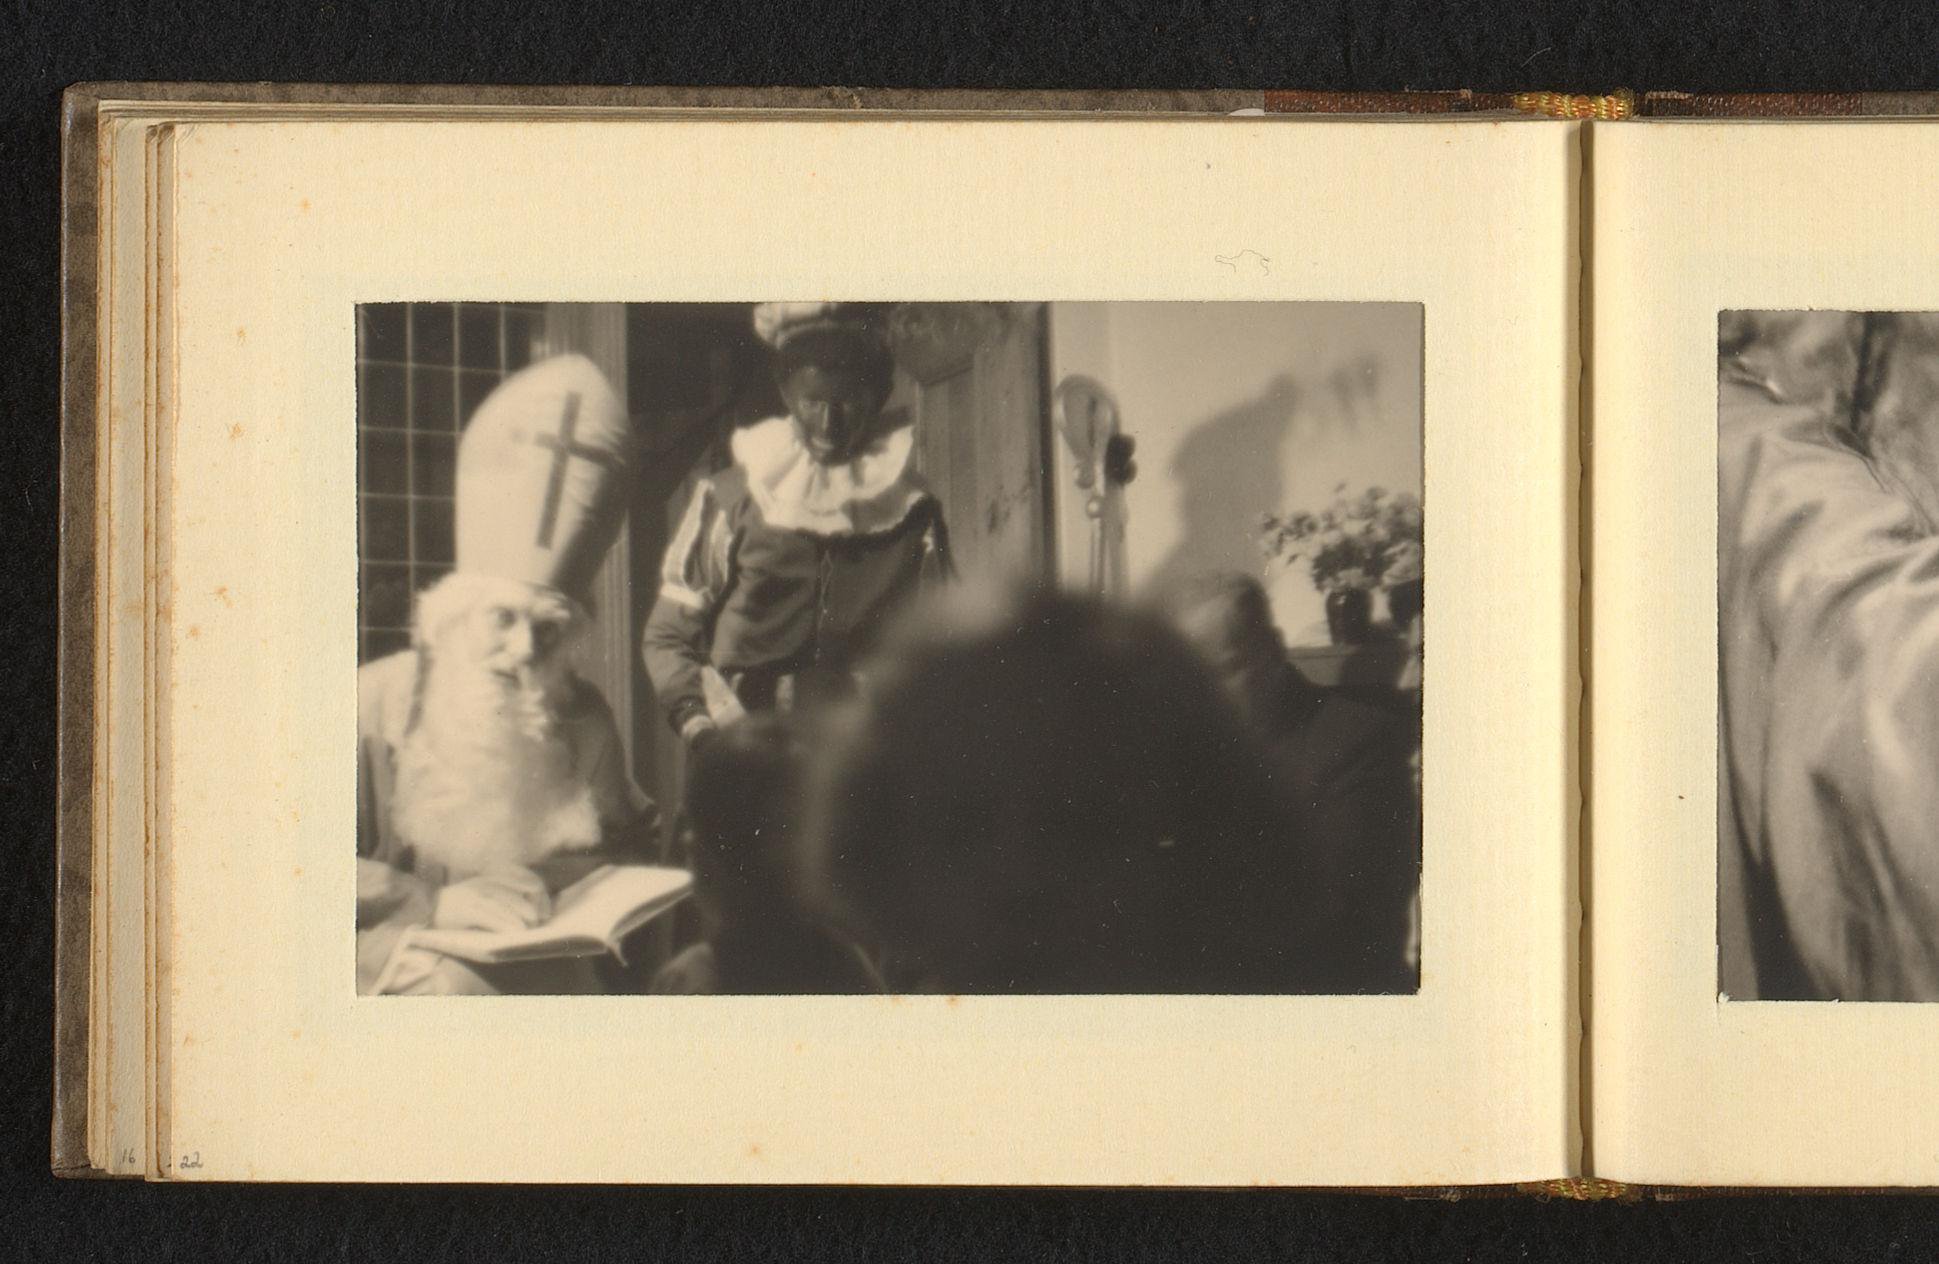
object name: album leaf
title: Sinterklaas en Piet in een woning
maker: norbert van den berg (1901-1972)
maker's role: amateurfotograaf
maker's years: 1901-1972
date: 1935-1950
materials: paper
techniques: gelatin silver print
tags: festivities on st. nicholas (eve) (december 5), saint nicholas day